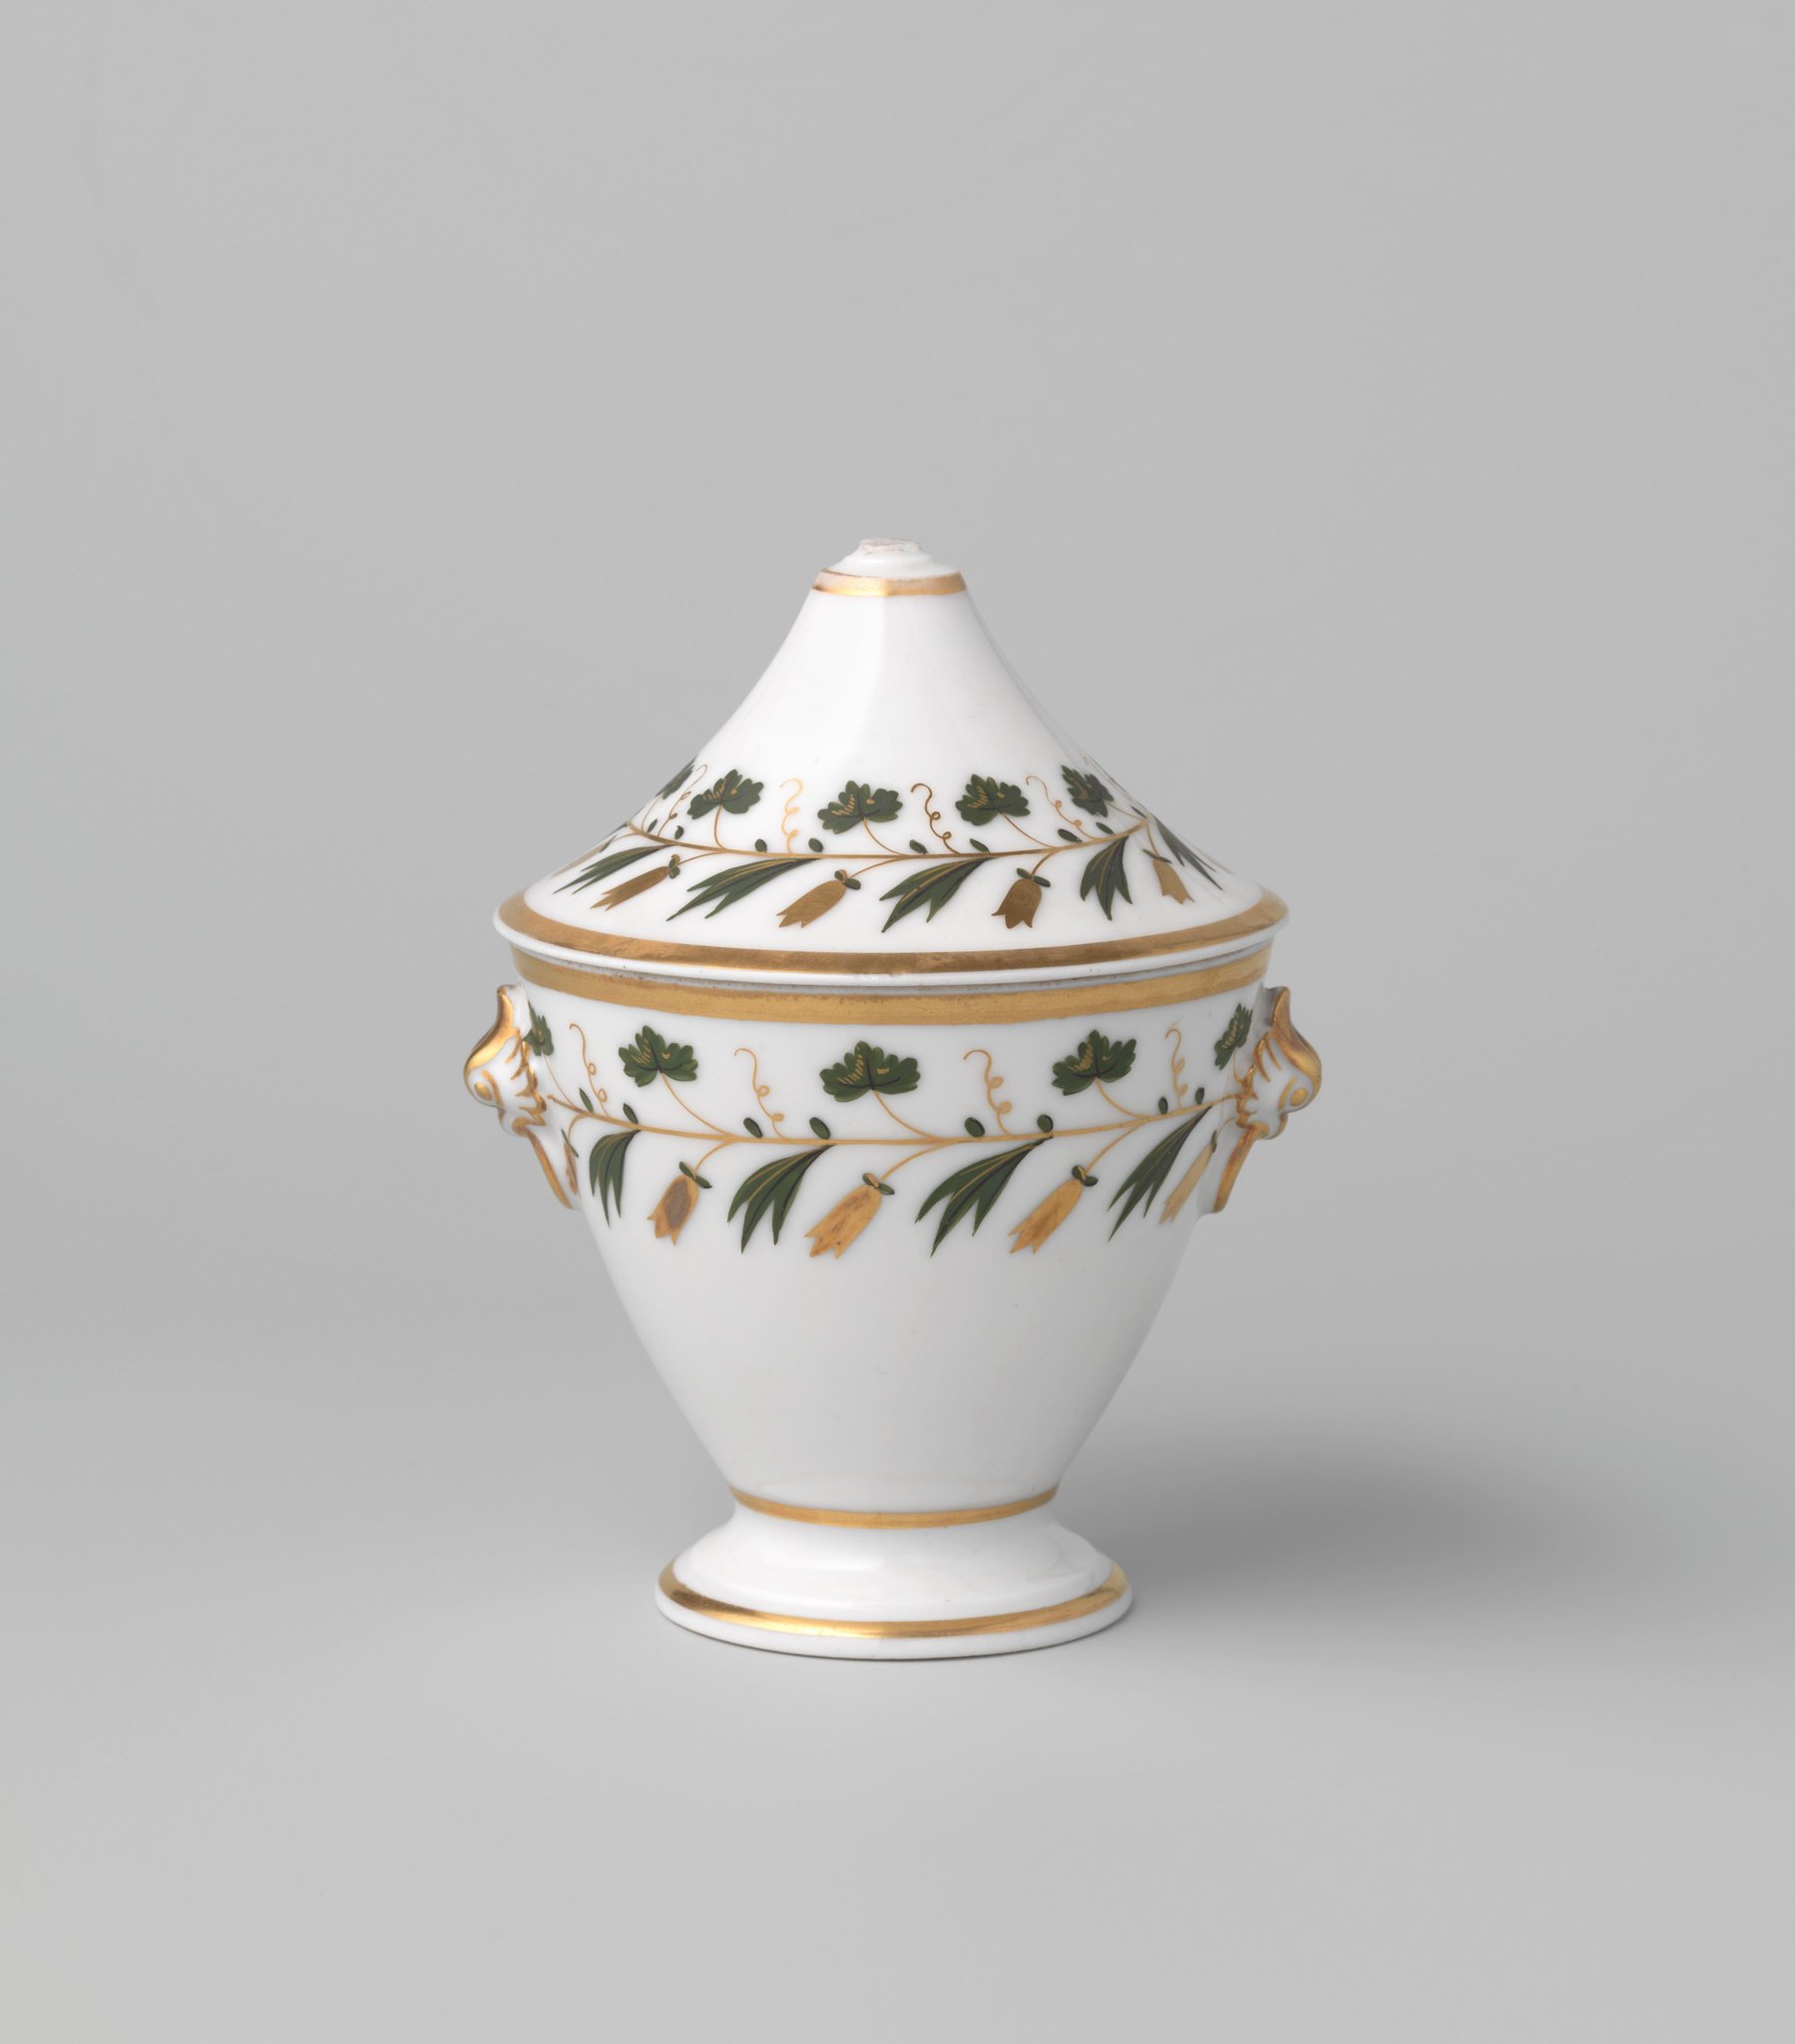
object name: sugar box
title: Sugar bowl with a foliate scroll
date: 1800-1824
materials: glaze, gold, paint, porcelain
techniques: firing, forming, gilding, turning, vitrification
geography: la courtille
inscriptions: mark: ‘gekruiste pijlen’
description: Suikerpot van porselein op hoge, spreidende voet en met twee gemodelleerde handvatten met ringen, beschilderd op het glazuur in groen, zwart en goud. Versierd op de wand met een band met aan de ene zijde wijnranken en aan de andere zijde bloemen en bladeren. Gouden lijnen op de voet en rand. Gemerkt op de onderzijde met de gekruiste pijlen.